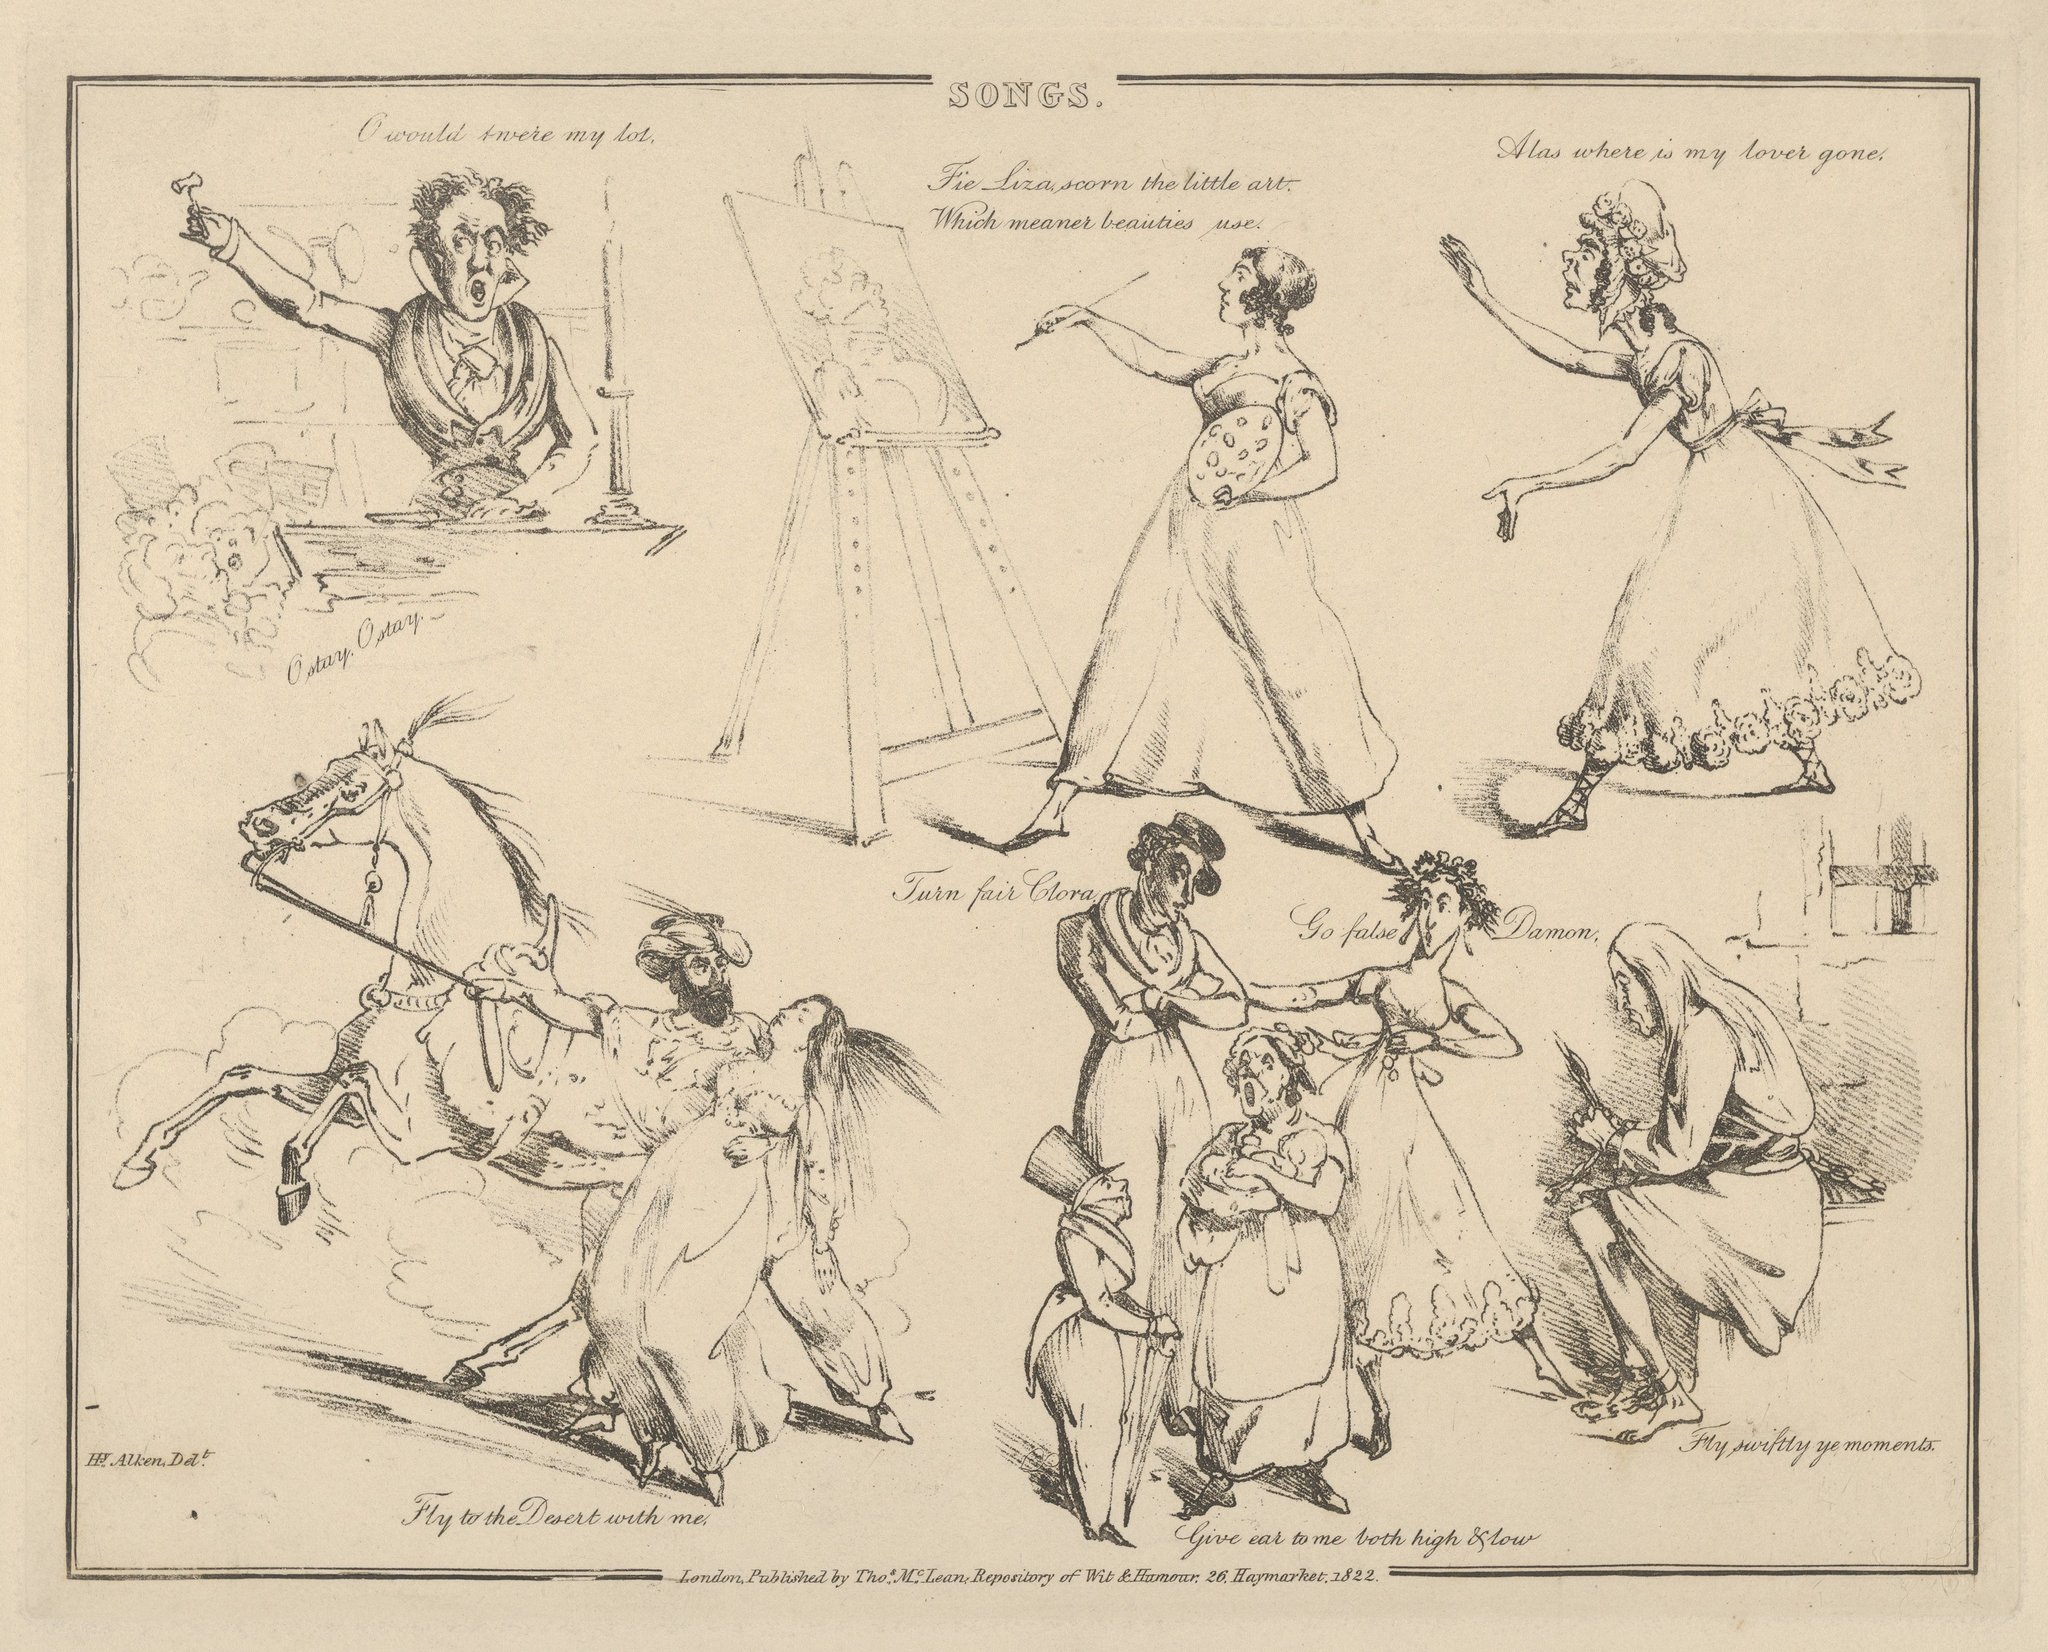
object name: print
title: Songs: "O would t'were my lot..."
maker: henry alken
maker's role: artist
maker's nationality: british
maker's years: 1785-1851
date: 1822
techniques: etching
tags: painting,satire,men,women,horses